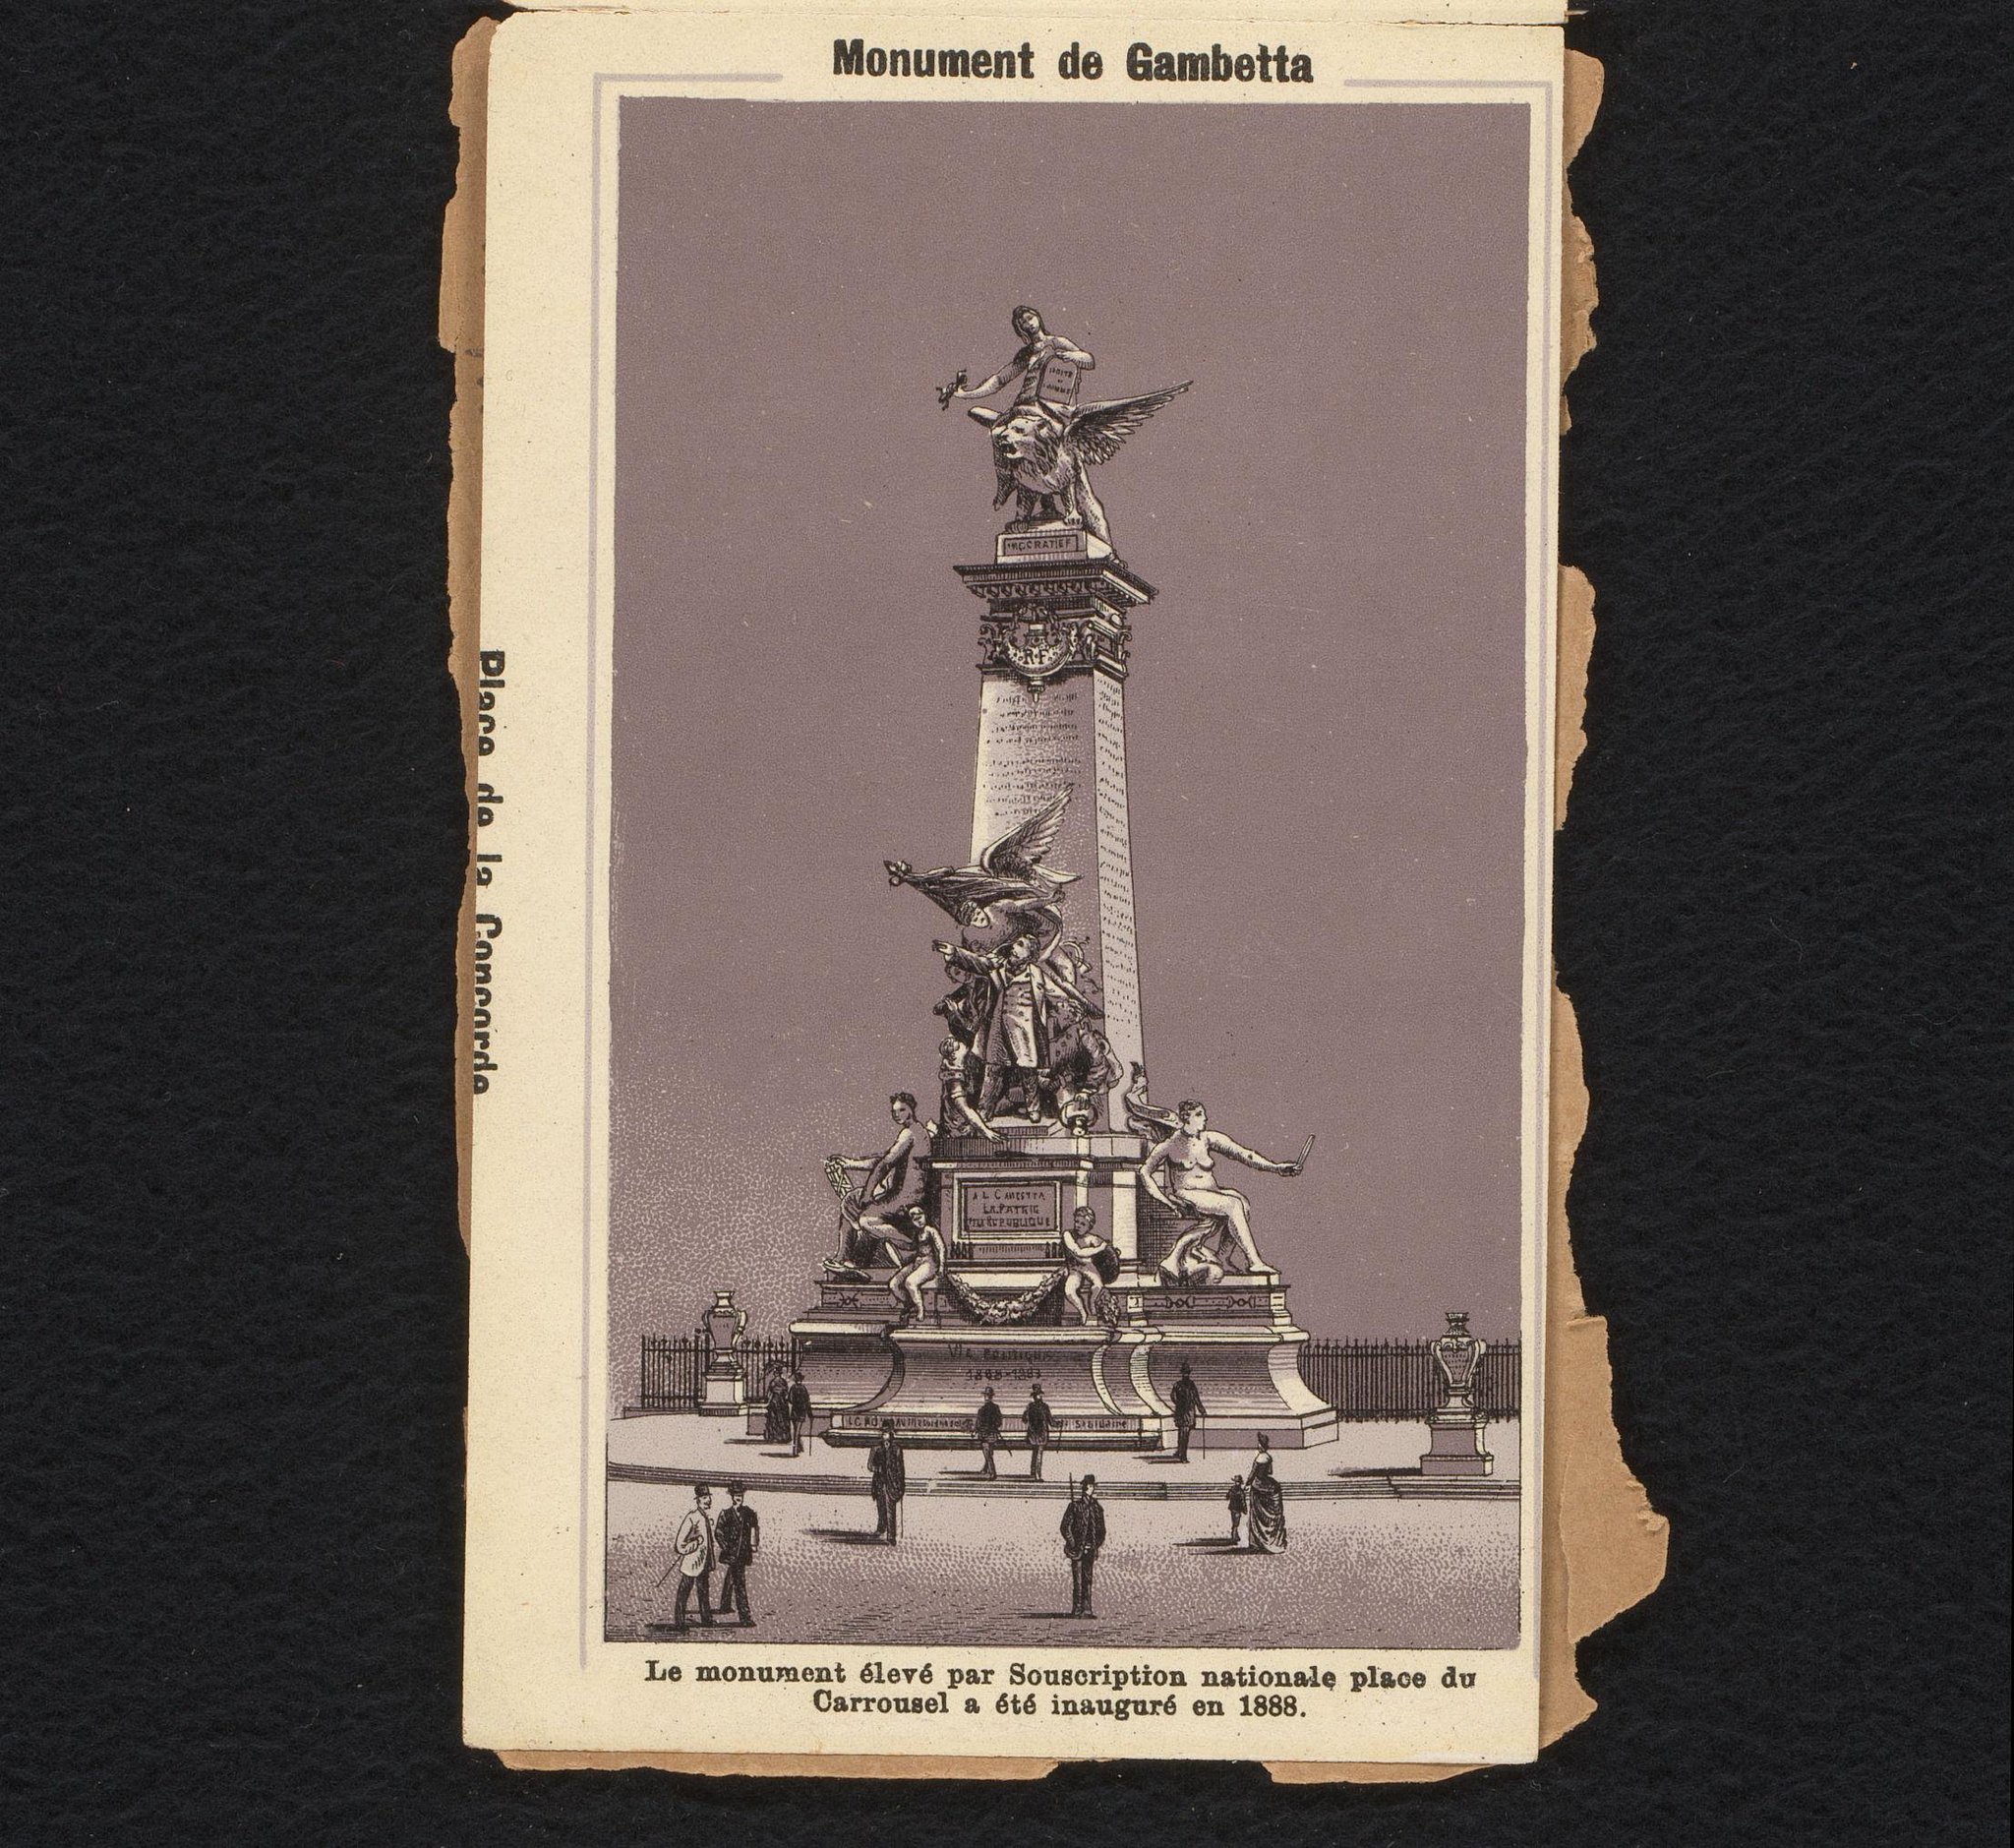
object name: print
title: Monument de Gambetta. Le monument élévé par souscription nationale, Place du Carrousel, a été inauguré en 1888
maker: Anonymous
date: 1890-1910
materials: cardboard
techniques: lithograph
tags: monument, statue, square, place, circus, etc. (+ city(-scape) with figures, staffage)